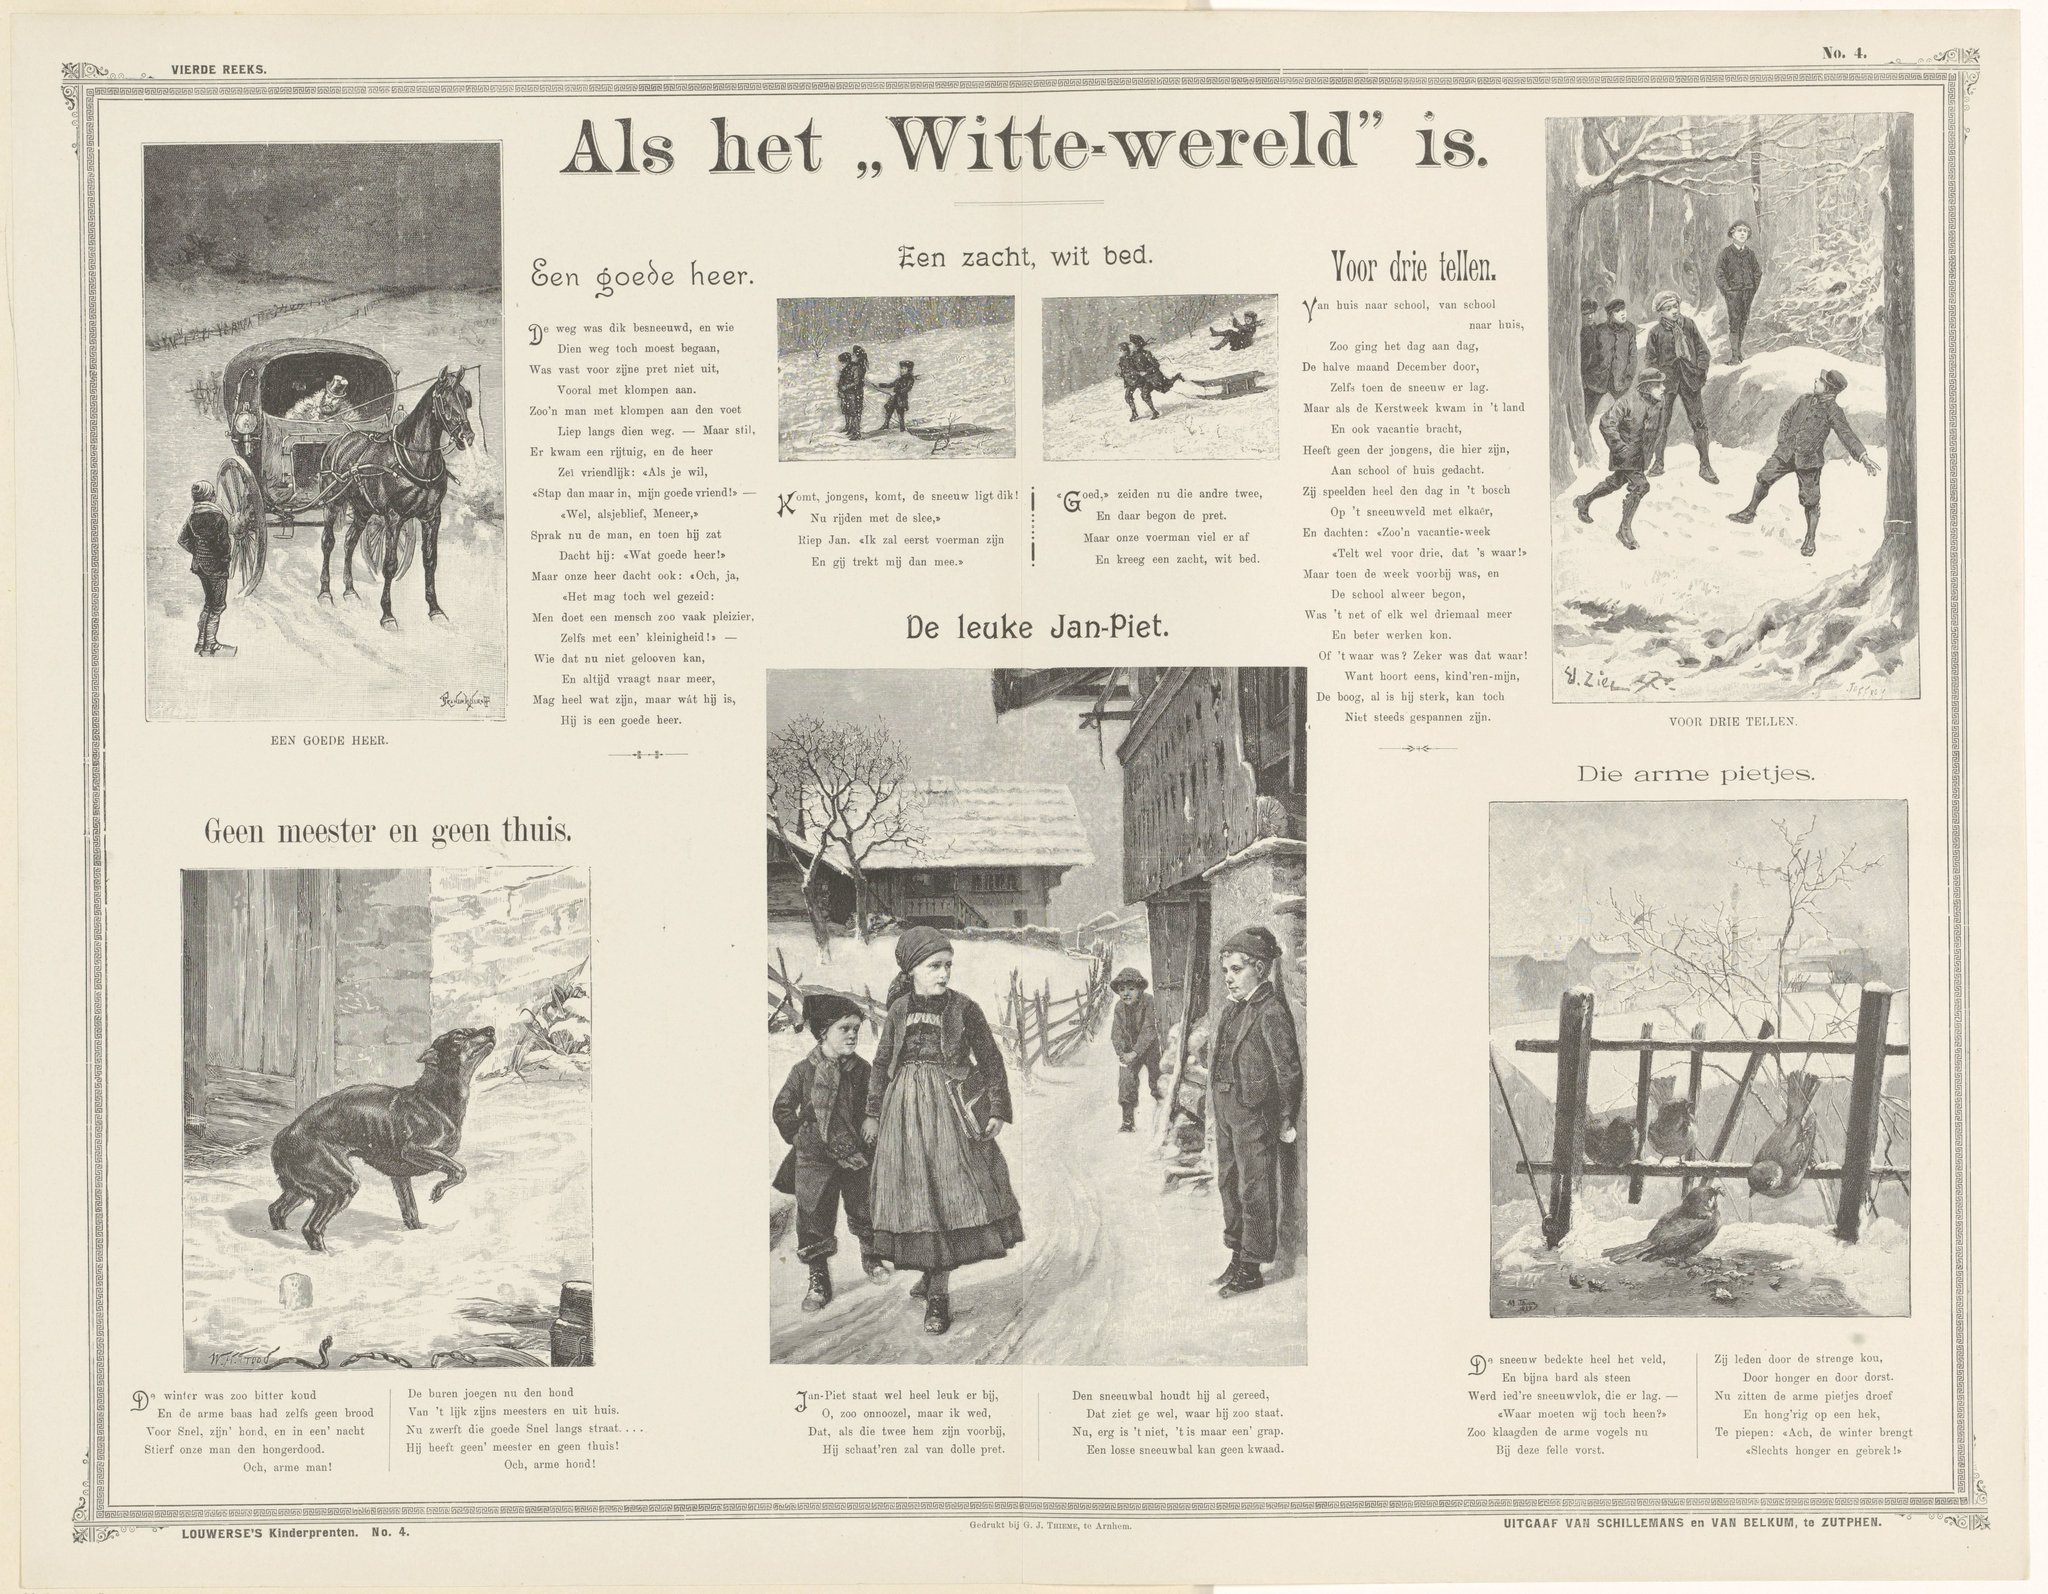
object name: popular print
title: Vierde reeks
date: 1905-1924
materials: paper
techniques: letterpress printing, printing block, engraving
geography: arnhem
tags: birds, snow, throwing snowballs, playing with snow and ice, dog, small sleigh (winter sports)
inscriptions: collector's mark: Lugt 2760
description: Blad met 7 voorstellingen van taferelen in de sneeuw, zoals spelende kinderen en dieren in de sneeuw. Tussen de afbeeldingen versjes in boekdruk. Genummerd rechtsboven en linksonder: No. 4.